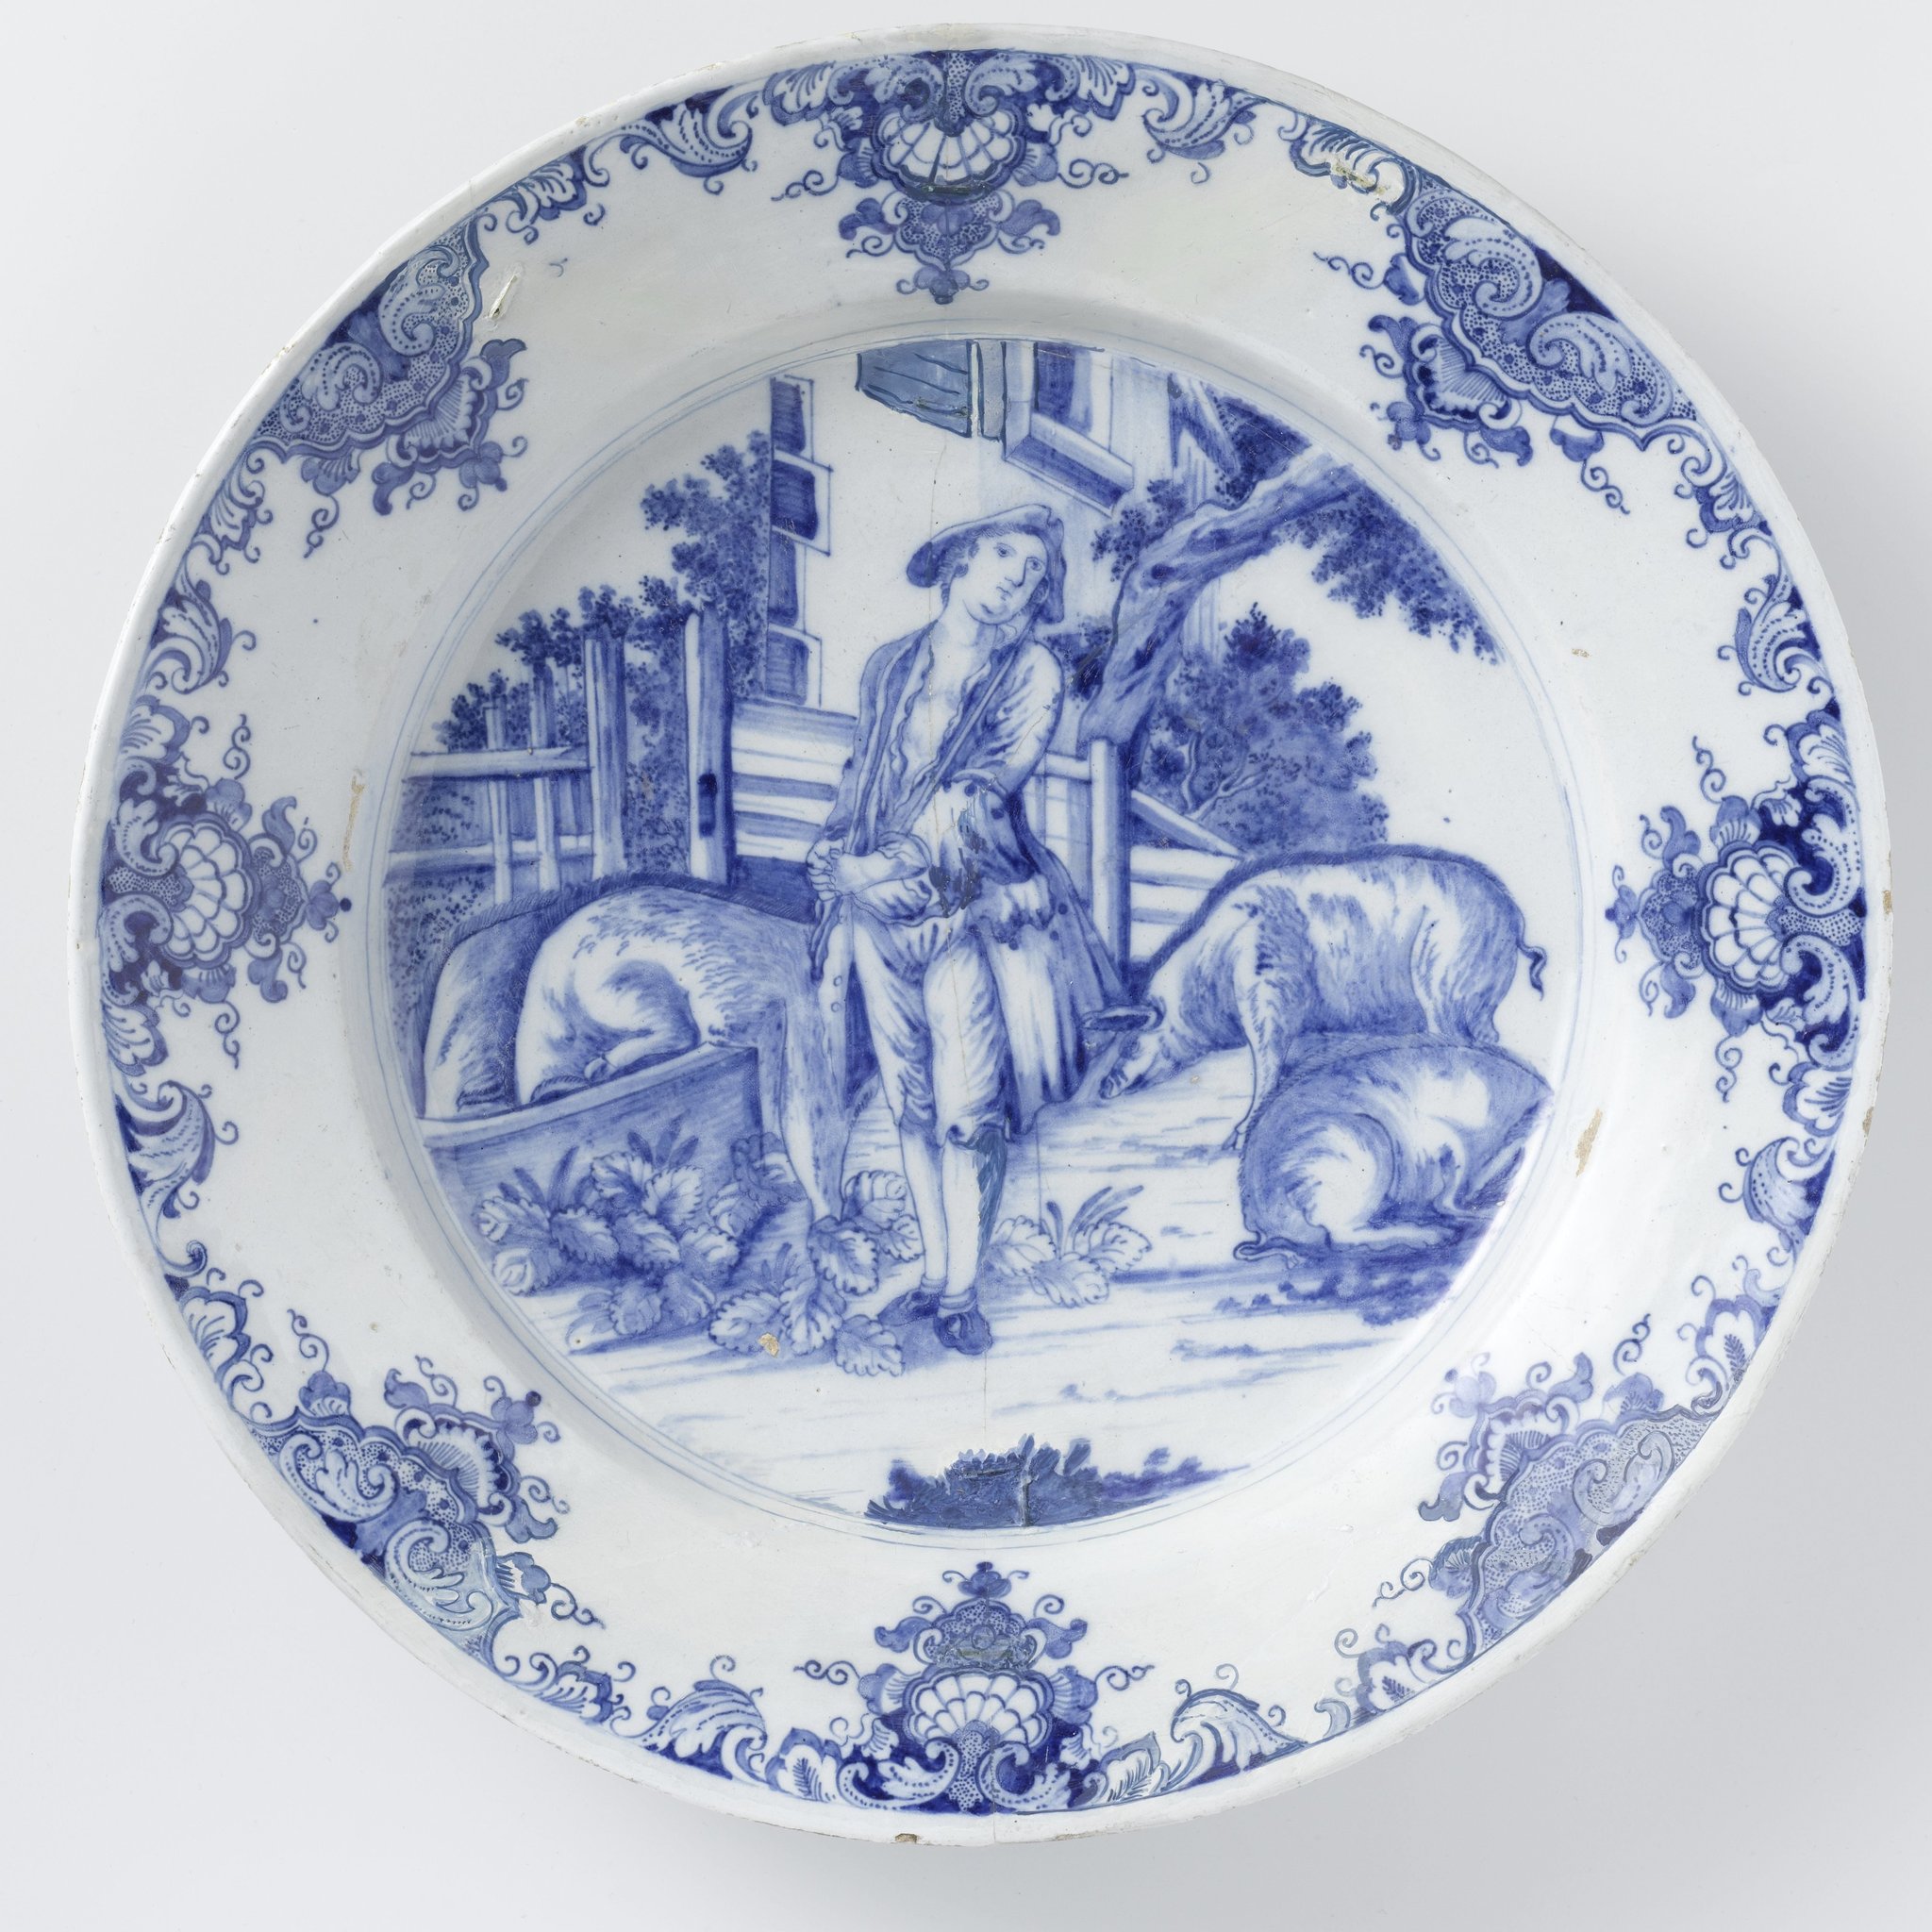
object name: platter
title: Schotel van faïence met de verloren zoon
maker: Anonymous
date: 1740-1775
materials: faience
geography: delft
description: Schotel van faïence. Blauw beschilderd met een scene uit 'De Verloren Zoon'.